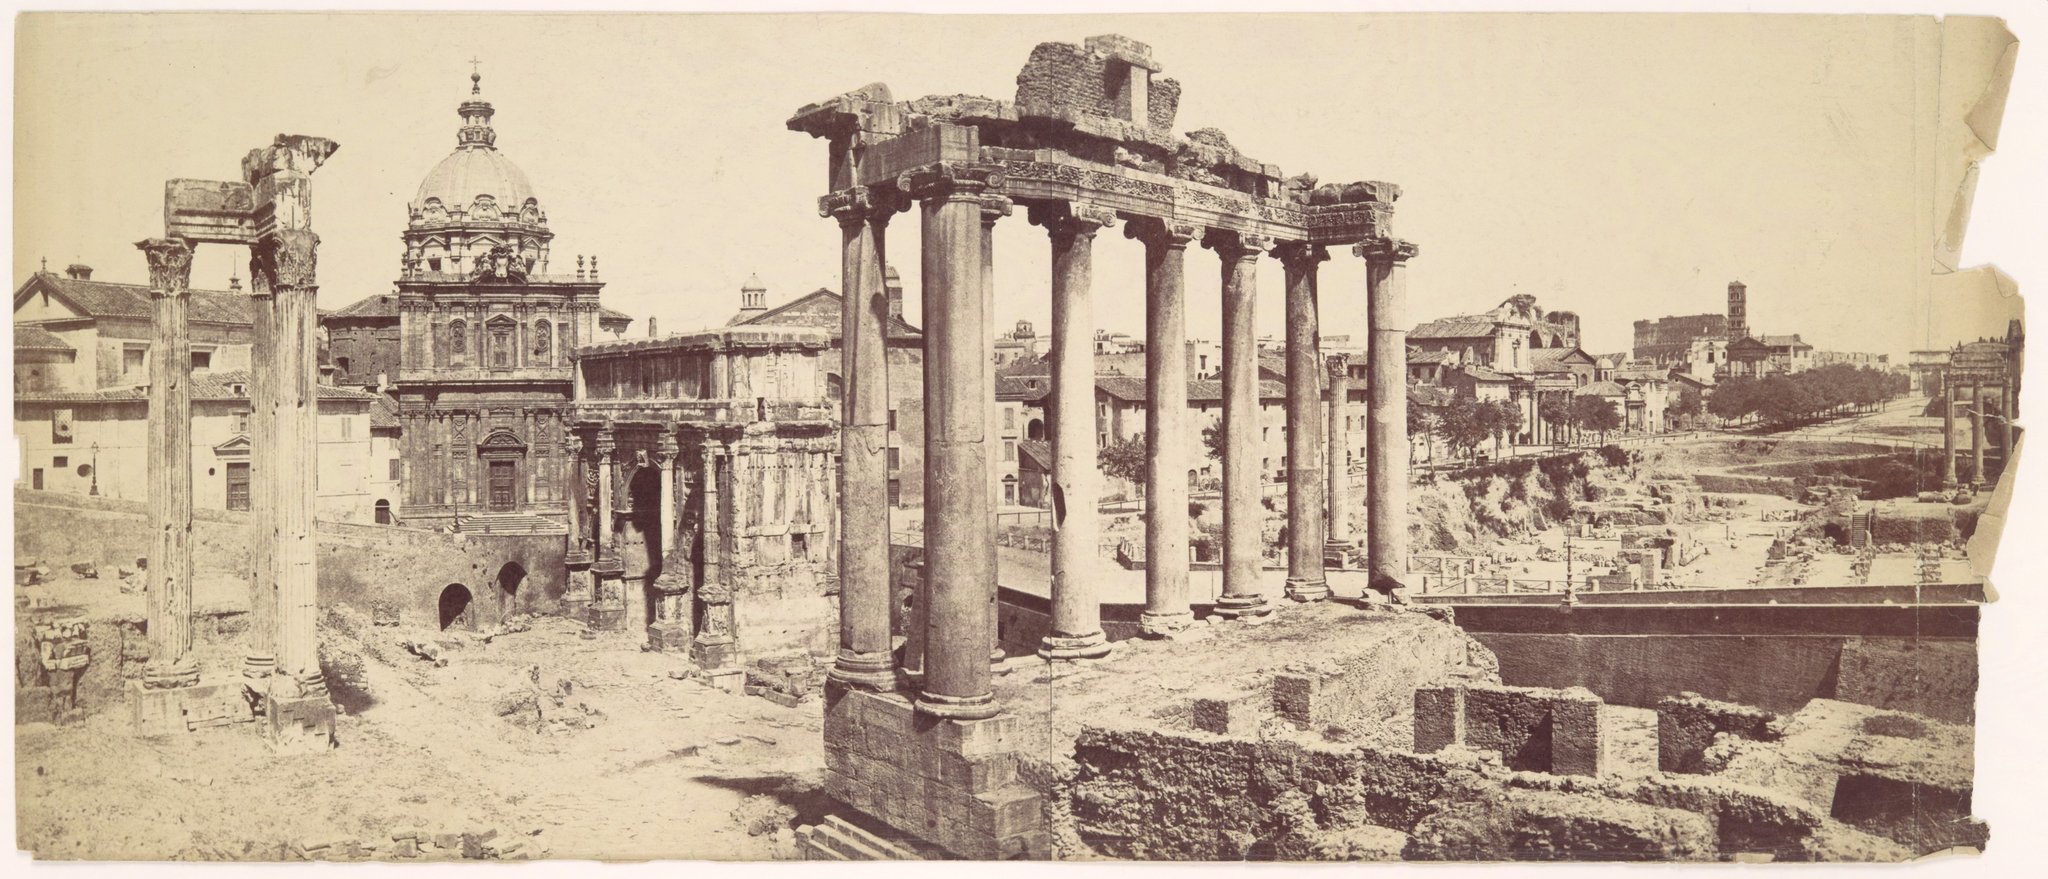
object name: photograph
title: [The Roman Forum]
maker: félix bonfils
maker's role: fotograaf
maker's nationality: french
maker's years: 1831-1885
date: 1870-1879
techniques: albumen silver print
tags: architecture,columns,ruins